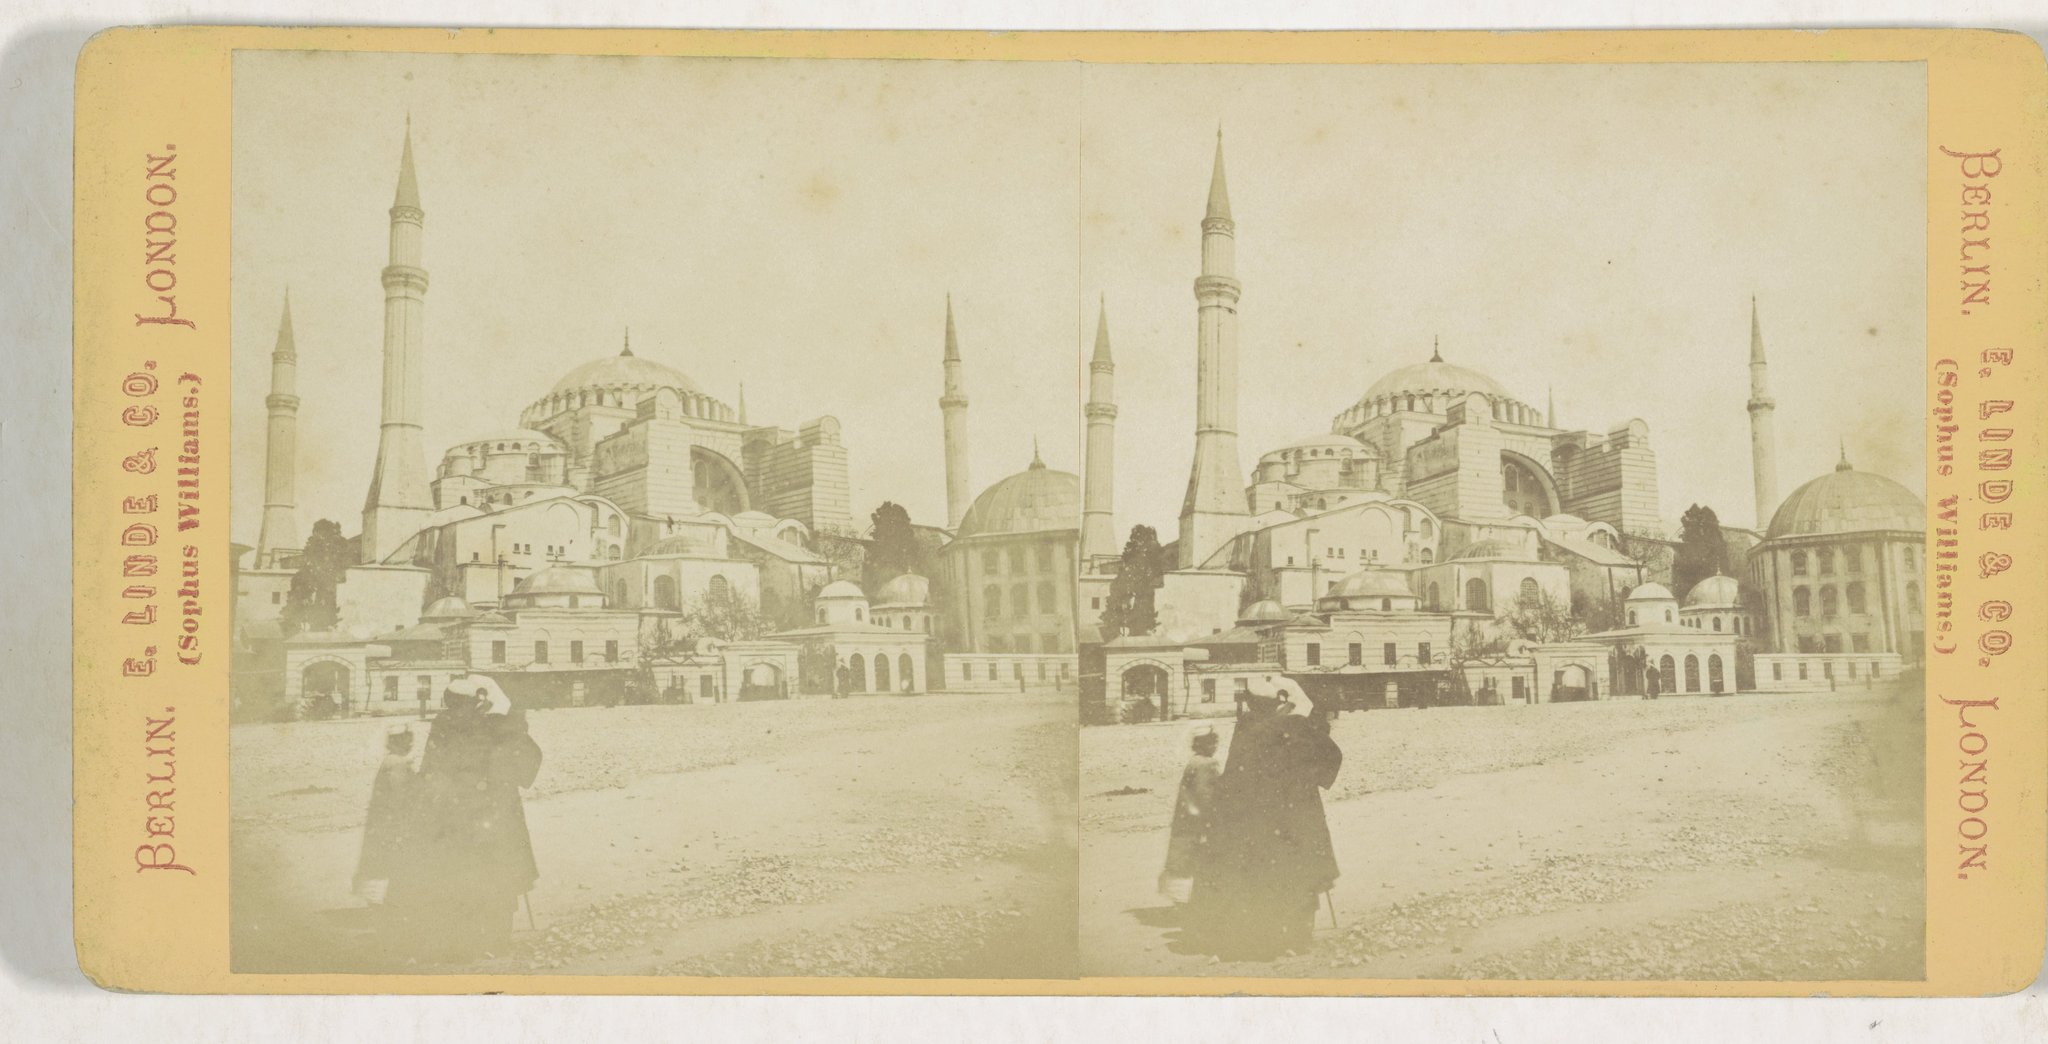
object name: stereograph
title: Sancta Sophia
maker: Anonymous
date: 1873-1890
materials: cardboard, paper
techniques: albumen print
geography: hagia sophia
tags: temple, shrine ~ islam, mohammedanism